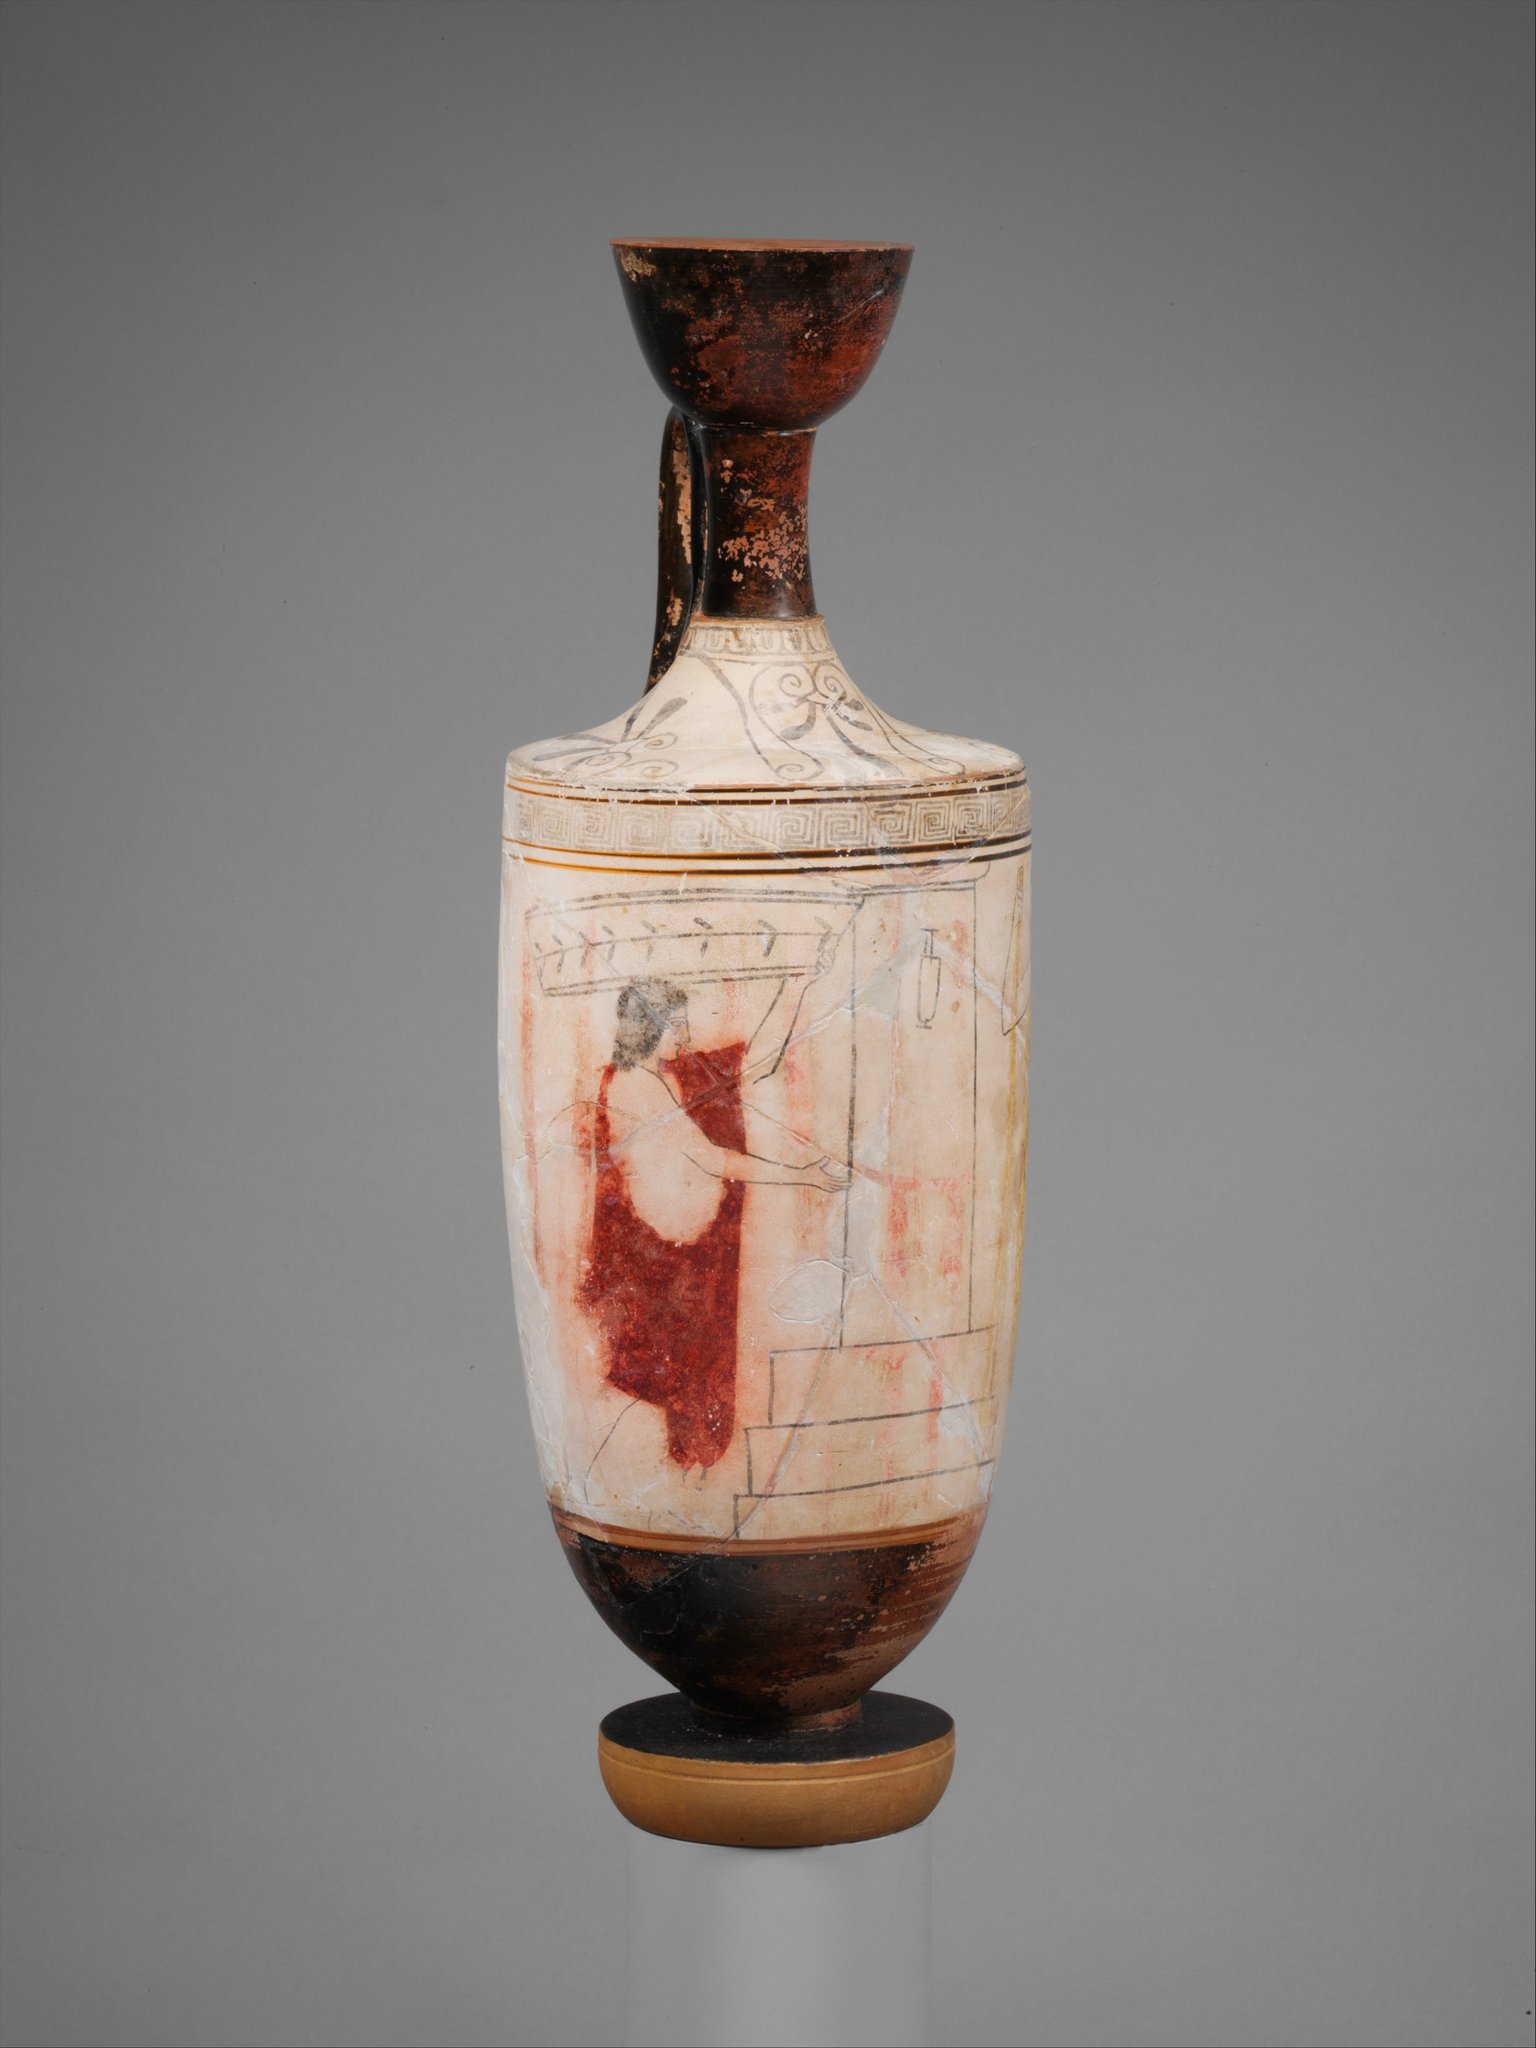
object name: lekythos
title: Terracotta lekythos (perfume flask)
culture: greek, attic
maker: sabouroff painter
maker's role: artist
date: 460 BCE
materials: terracotta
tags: human figures